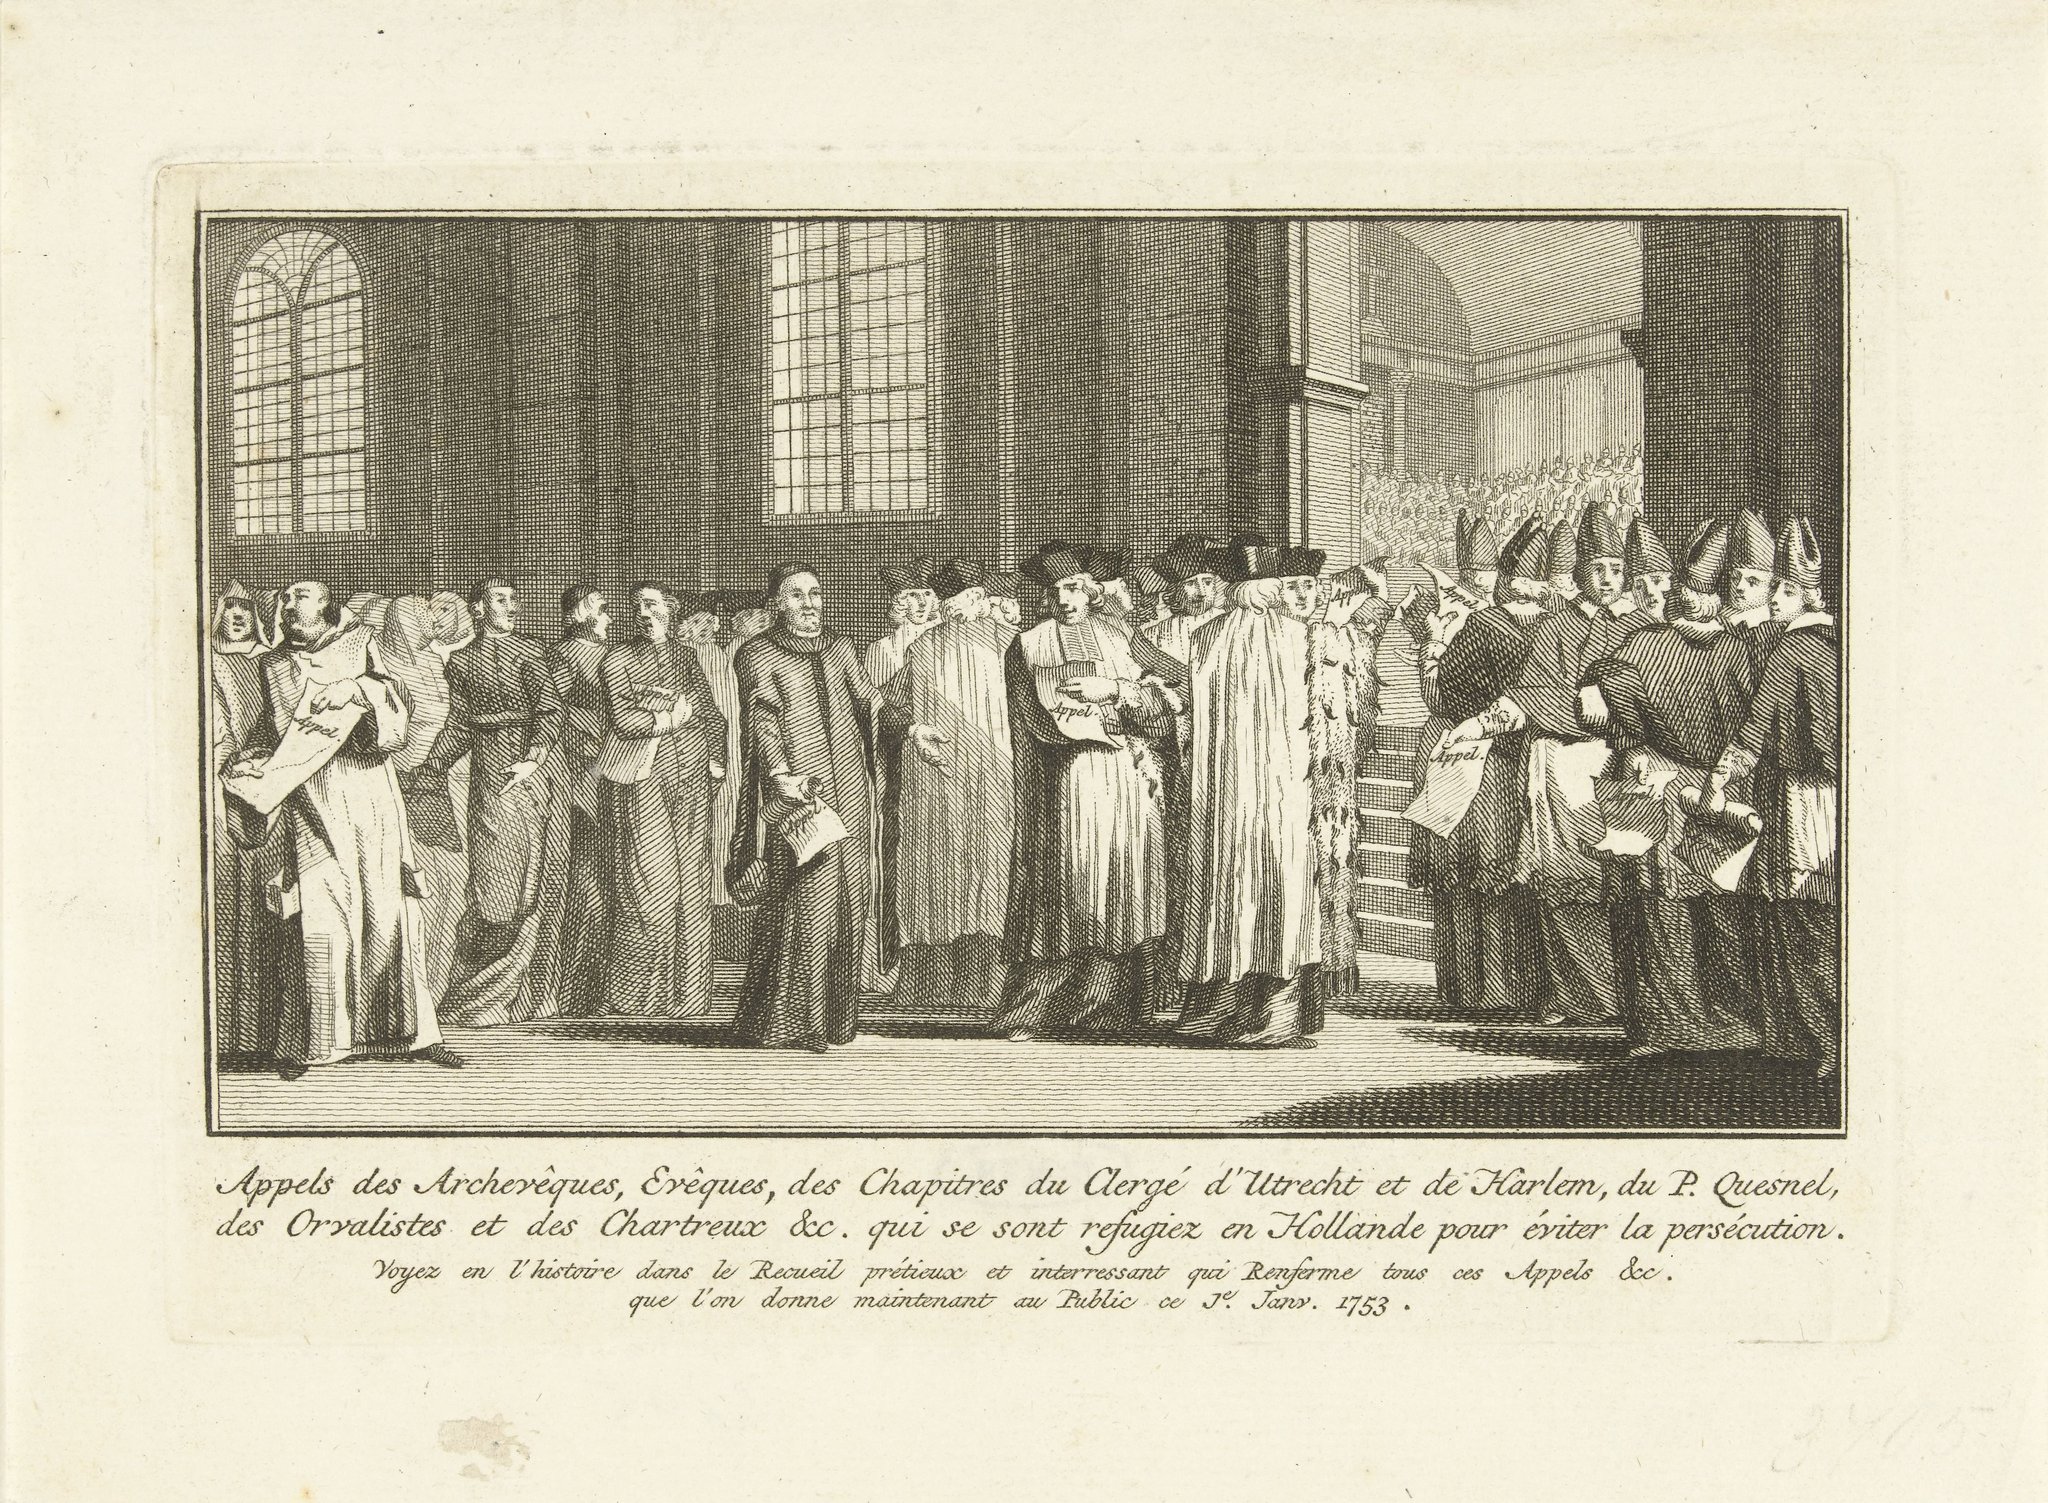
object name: print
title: Appels des Archevêques, Evêques, des Chapitres du Clergé d'Utrecht et de Harlem, du P. Quesnel des Orvalistes et des Chartreux &c. qui se sont refugiez en Hollande pour éviter la persécution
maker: Anonymous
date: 1753-1799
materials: paper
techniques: etching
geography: netherlands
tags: amsterdam, representants of the church (christians in general, laymen, monks, etc.) in strife with each other or with opponents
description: Het appèl van de jansenisten en alle andere gevluchte katholieke geestelijken in ballingschap tijdens een kerkvergadering van katholieke geestelijken van Utrecht en Haarlem, naar aanleiding van de publicaties van Pasquier Quesnel, ca. 1723.